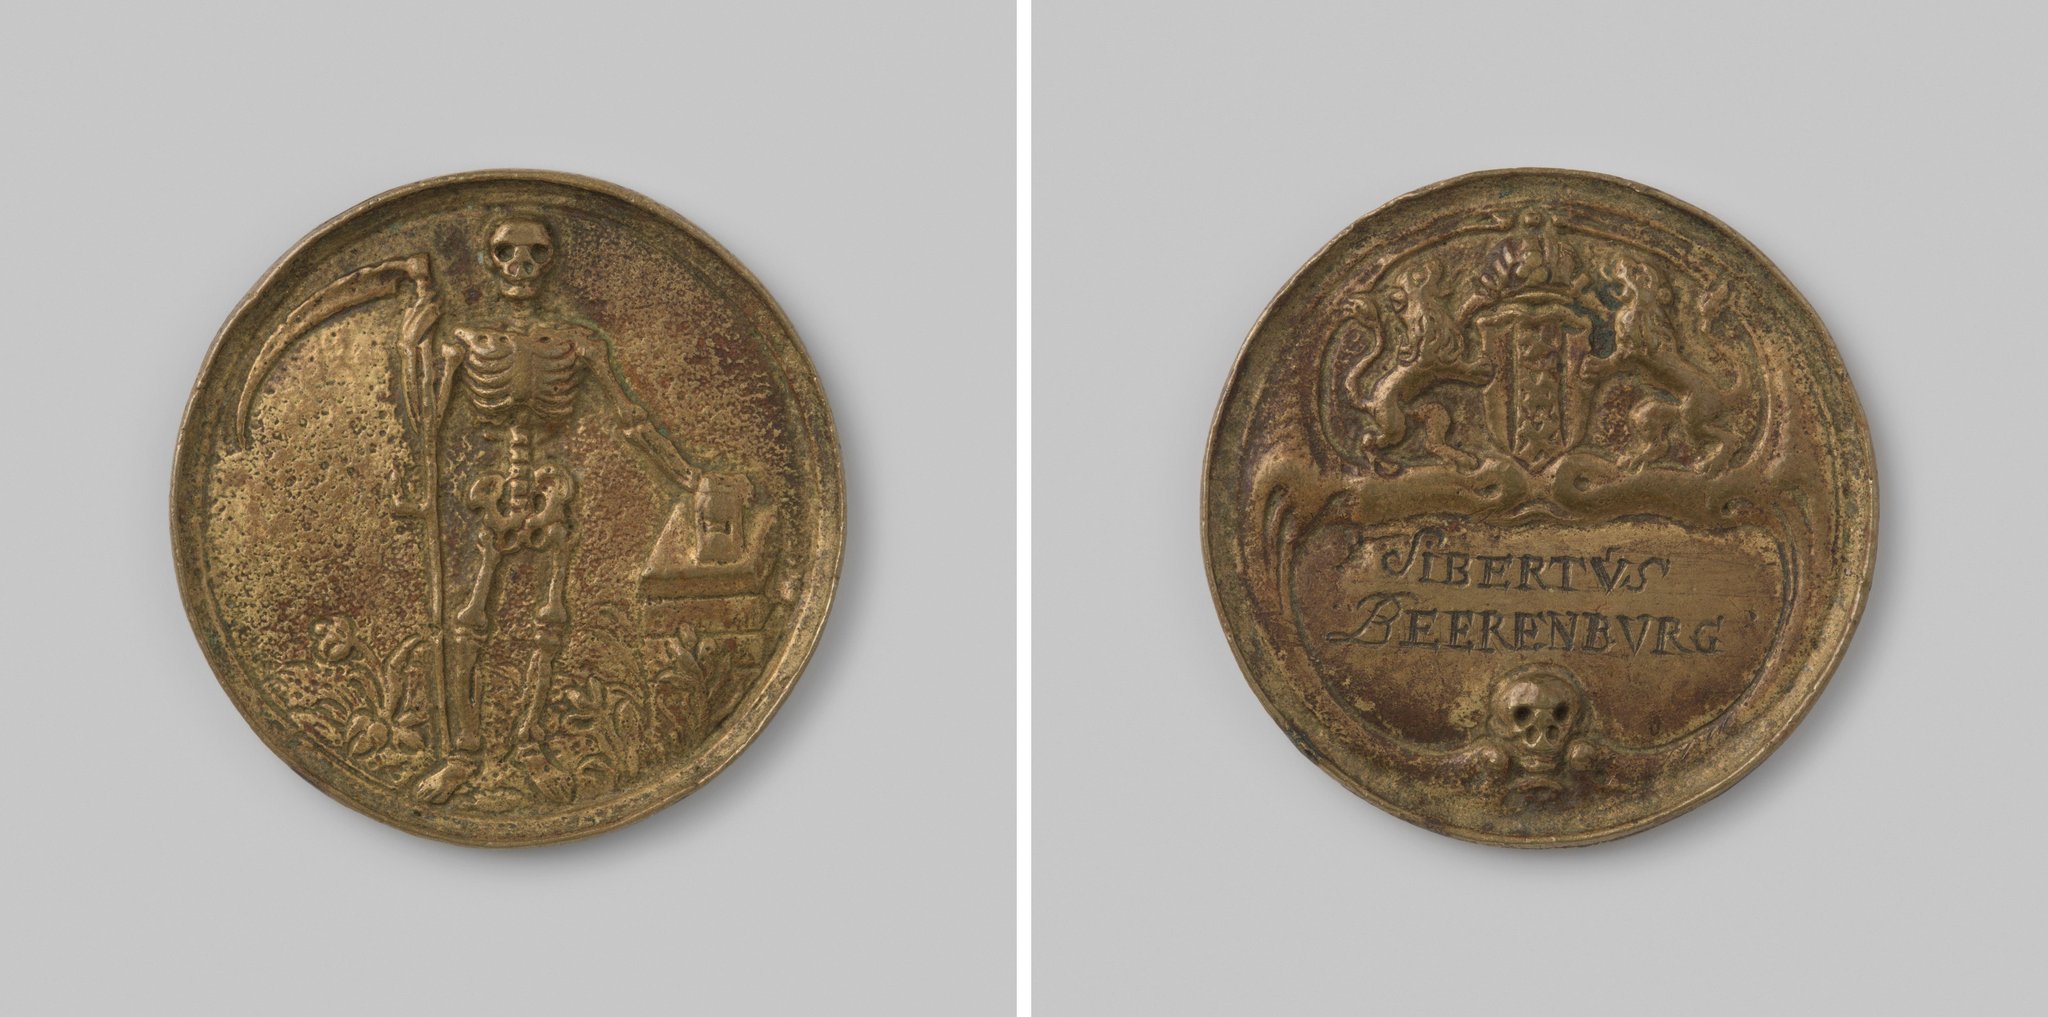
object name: medal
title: Presentiepenning van het Chirurchijnsgilde te Amsterdam 1654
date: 1654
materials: brass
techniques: casting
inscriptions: inscription: ‘SIBERTUS / BEERENBVRG’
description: Gegoten messing penning met op de voorzijde de Dood, met zeis en zandloper op altaar in een tuin, op de keerzijde boven het gekroonde wapenschild van Amsterdam met dragers en onder een inscriptieruimte en een doodshoofd, op naam van Sibertus Beerenburg